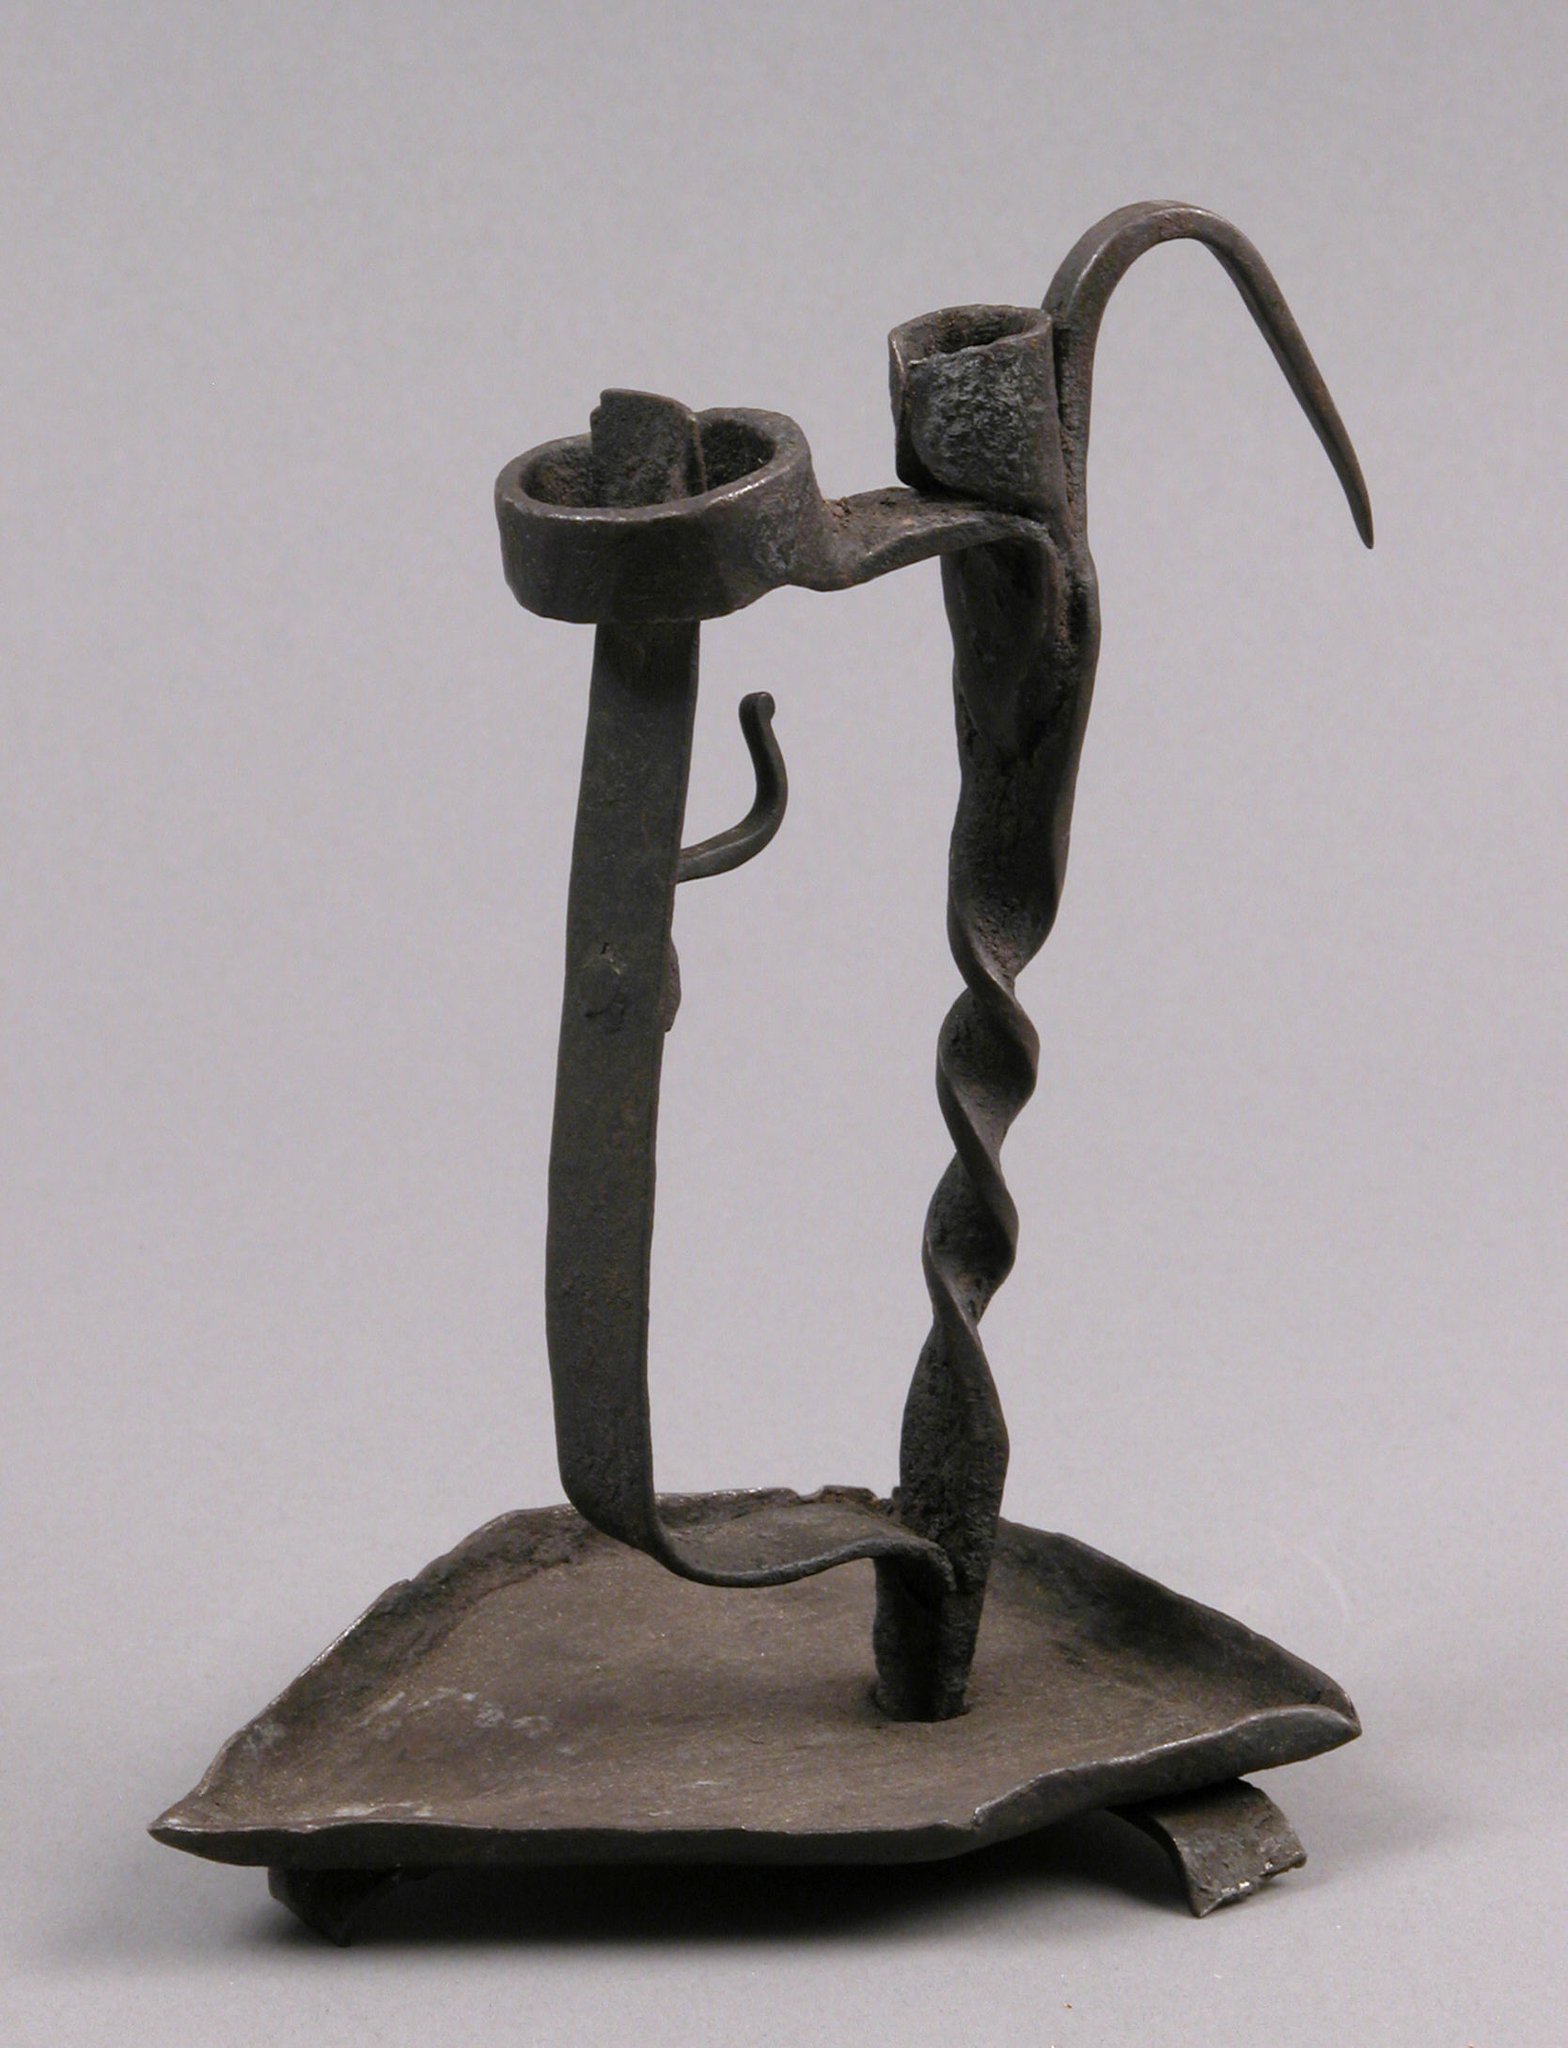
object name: candlestick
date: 1501-1600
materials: iron